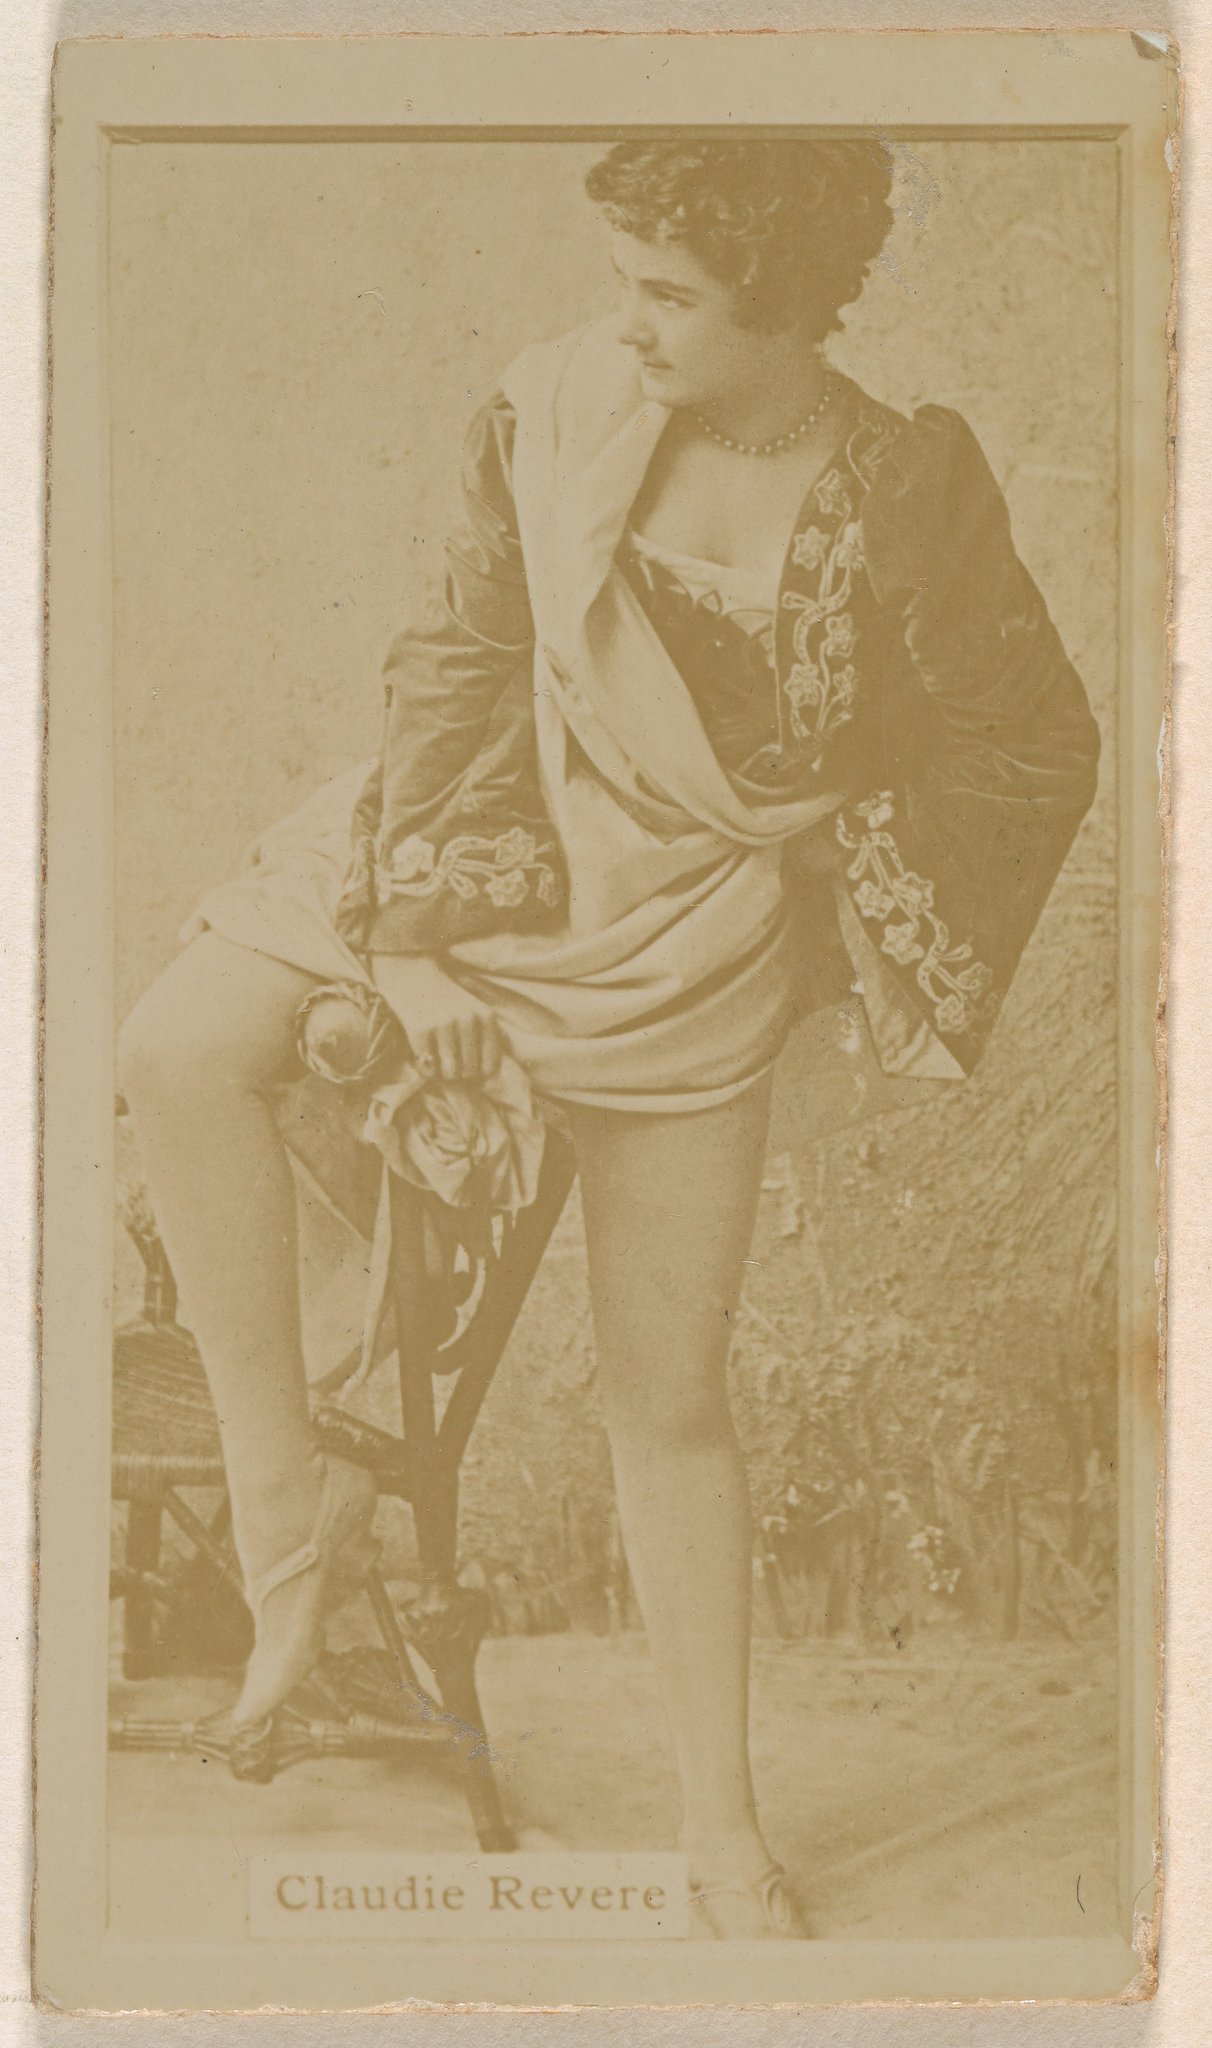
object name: photograph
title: Claudie Revere, from the Actresses series (N245) issued by Kinney Brothers to promote Sweet Caporal Cigarettes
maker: kinney brothers tobacco company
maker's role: publisher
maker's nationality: american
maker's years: 1869-2011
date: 1890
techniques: albumen silver print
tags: women,actresses